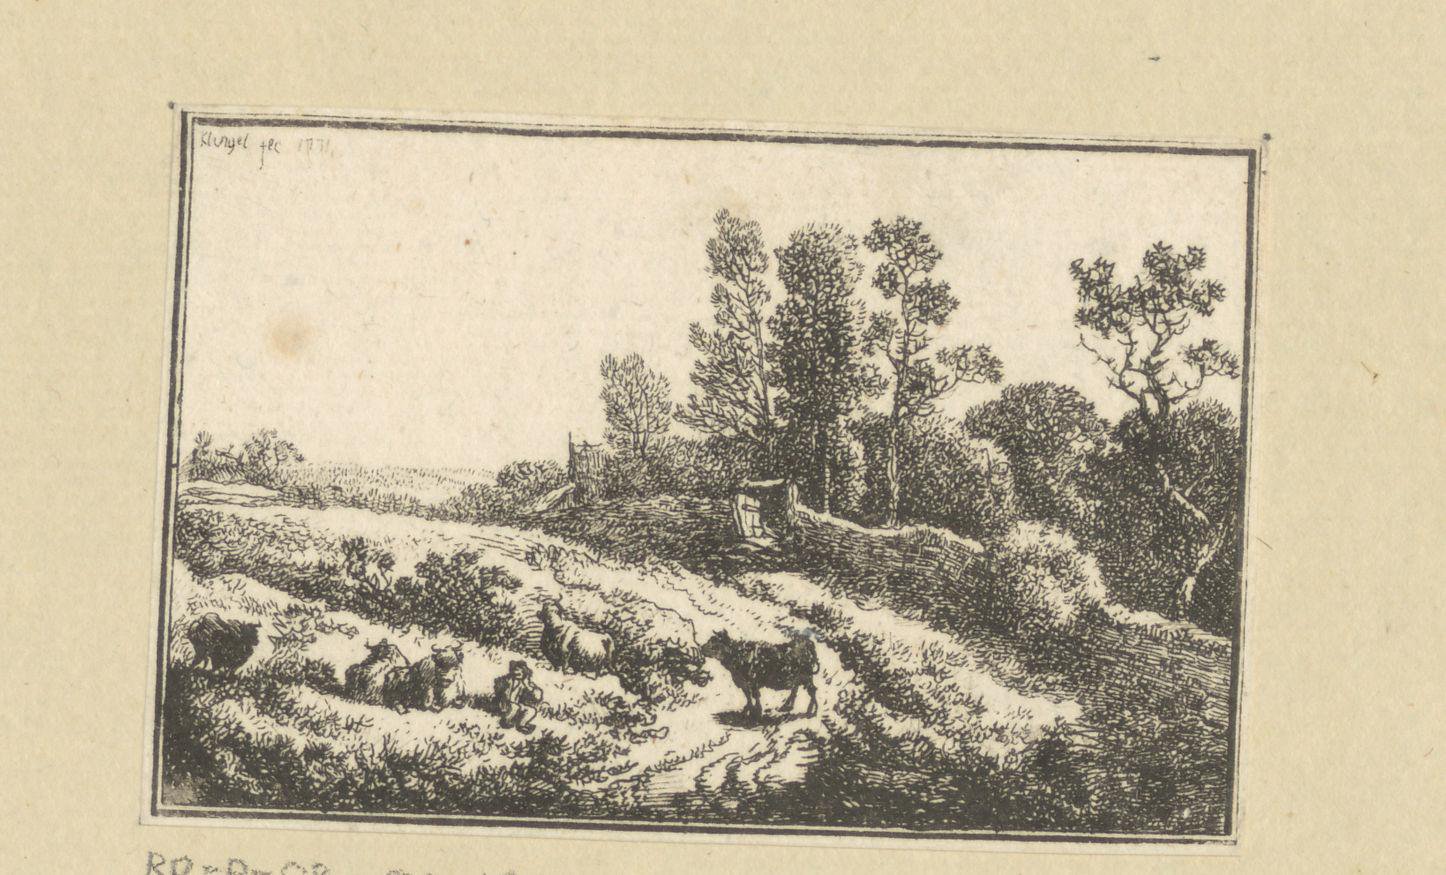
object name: print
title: Landschap met herder en kudde runderen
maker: johann christian klengel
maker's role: print maker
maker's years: 1751-1824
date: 1771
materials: paper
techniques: etching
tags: herding, herdsman, herdswoman, shepherd, shepherdess, cowherd, etc., cattle, rural housing, e.g. country-house, villa, cottage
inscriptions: collector's mark: Lugt 240